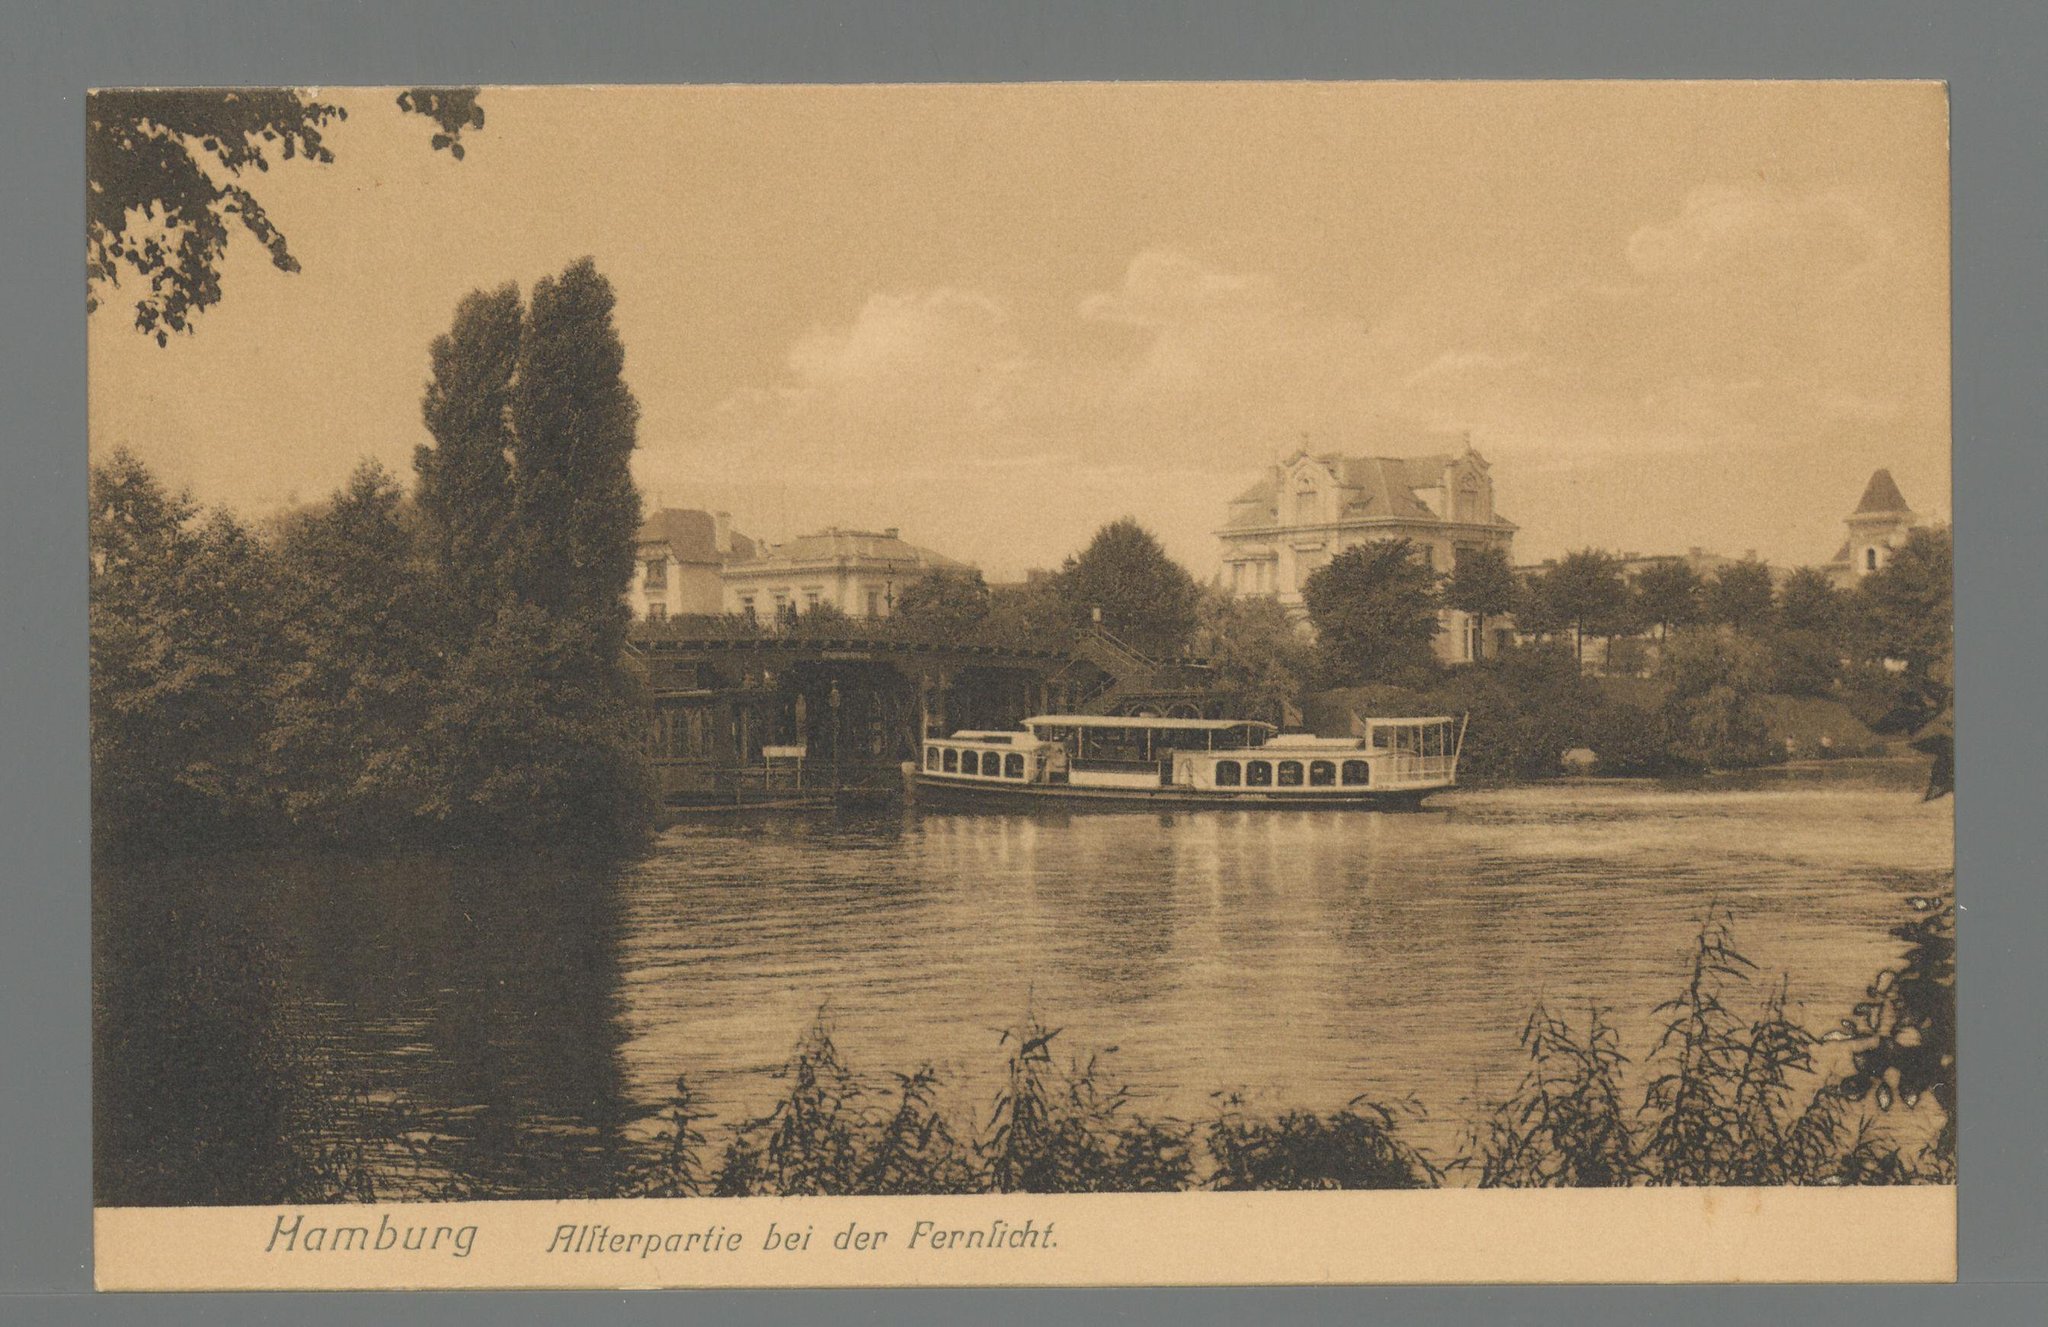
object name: photomechanical print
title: Luxusdruck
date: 1905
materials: cardboard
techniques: photograph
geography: hamburg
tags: canals, waters (in city), bridge in city across river, canal, etc.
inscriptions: date